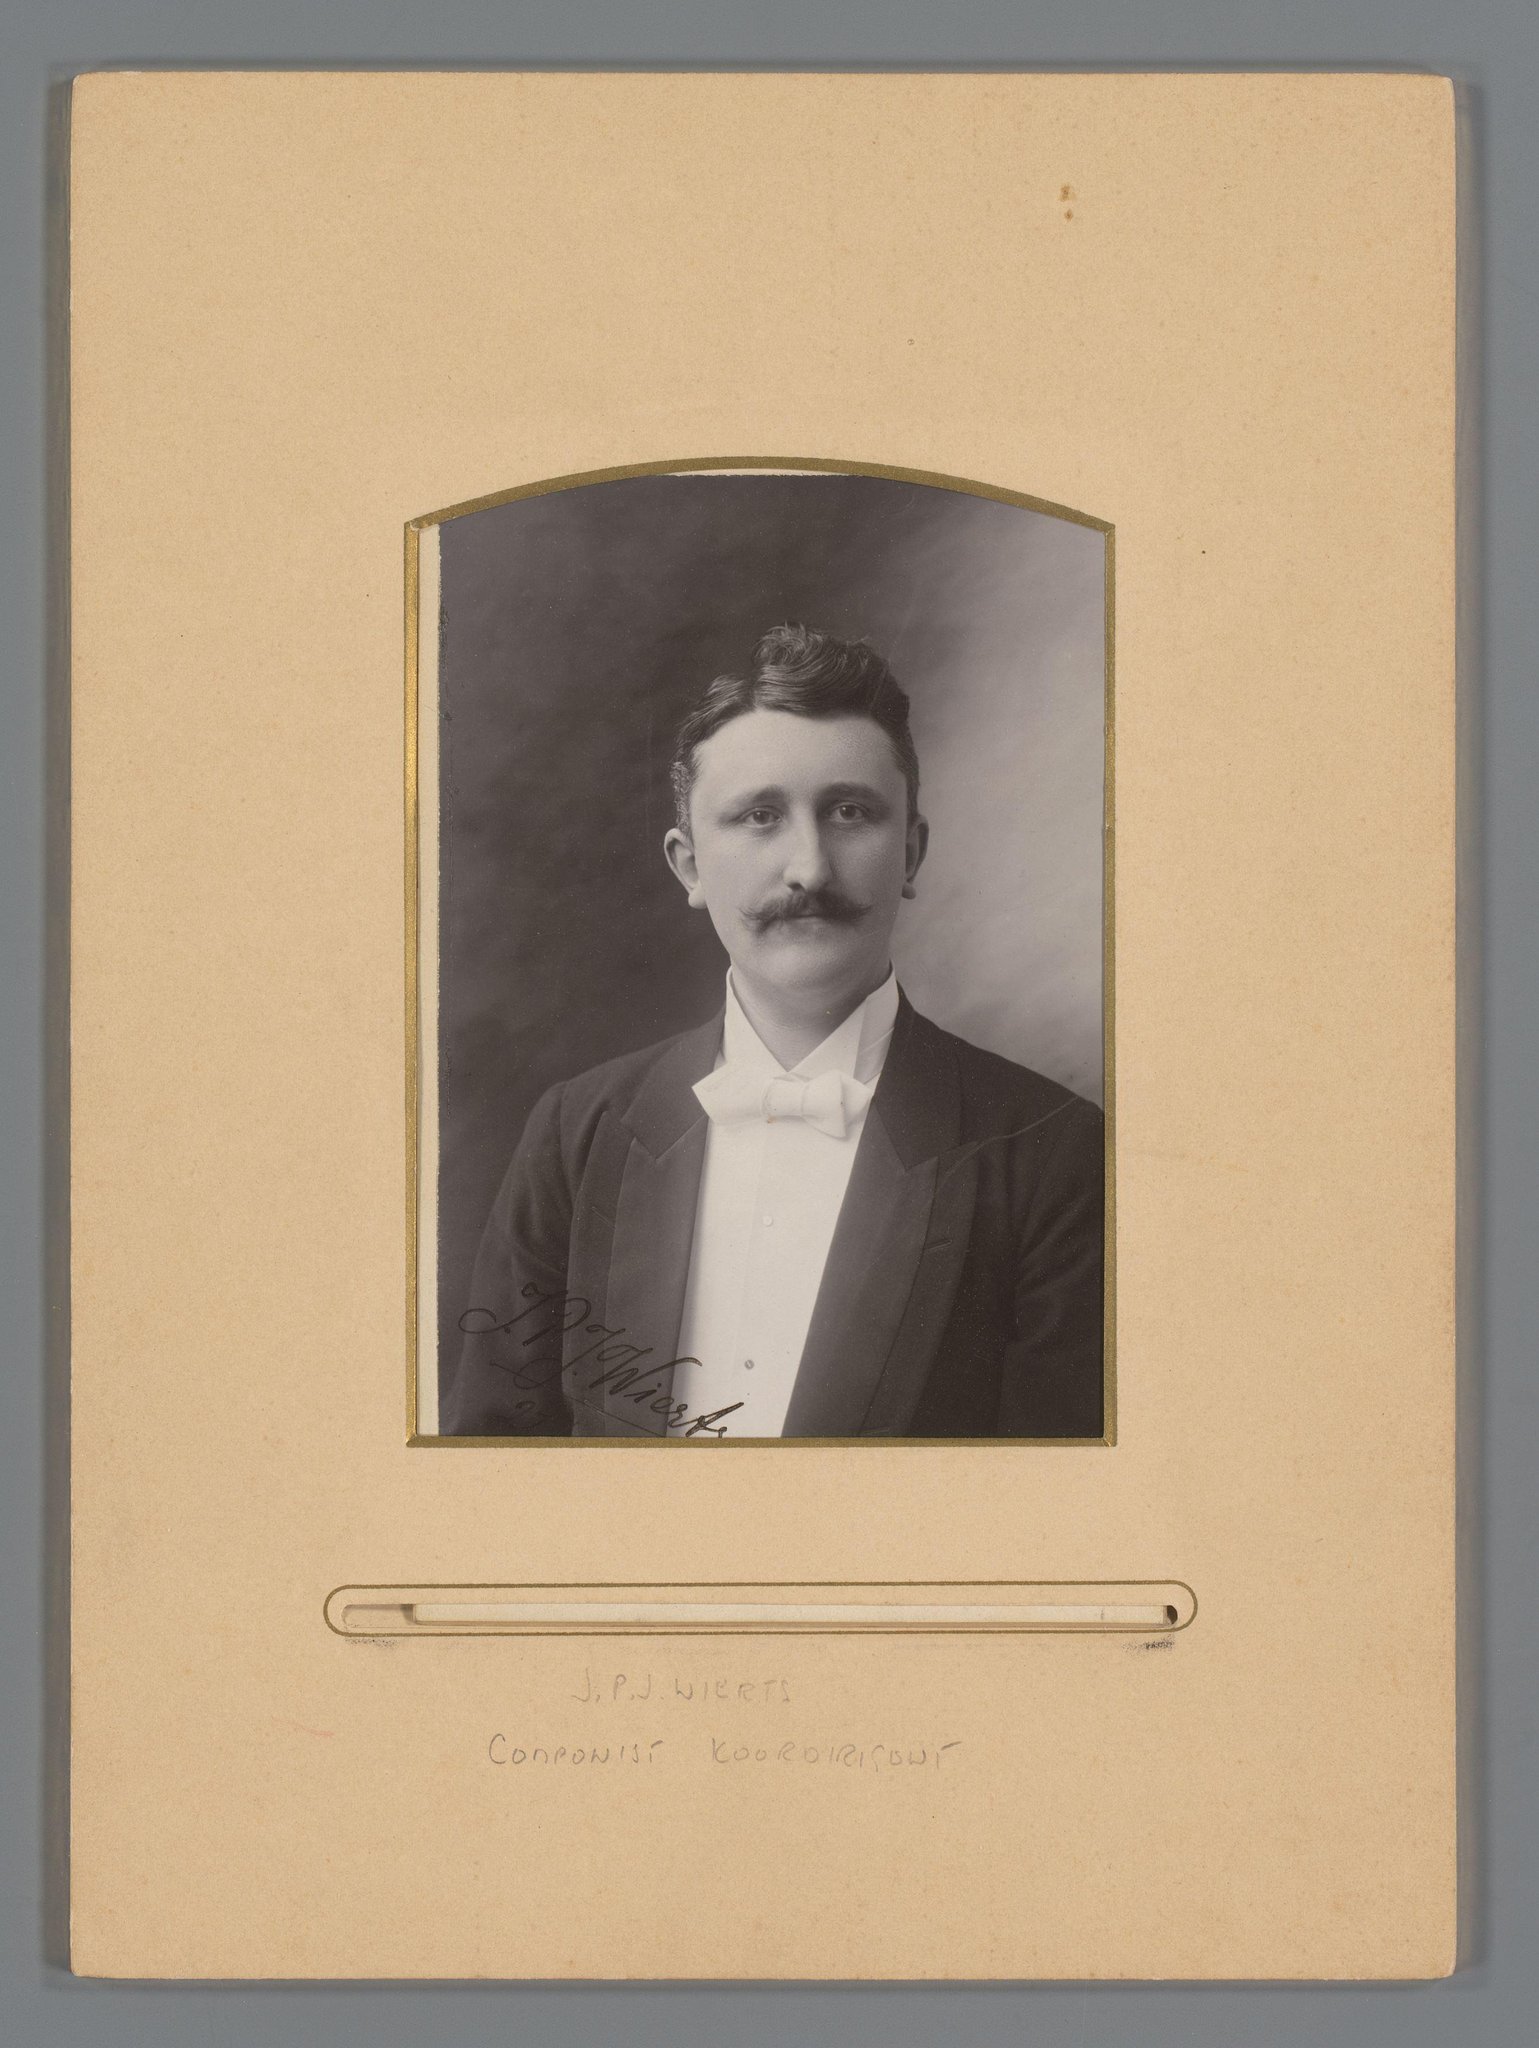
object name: photograph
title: Portret van componist J.P.J. Wierts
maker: charles abraas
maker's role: fotograaf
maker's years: 1873-1924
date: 1890-1920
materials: cardboard, photographic support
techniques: collodion silver print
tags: adult man, historical persons, portrait of composer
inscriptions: annotation: ‘J.P.J. Wierts’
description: Deze foto maakt deel uit van een omslag met 22 foto's.